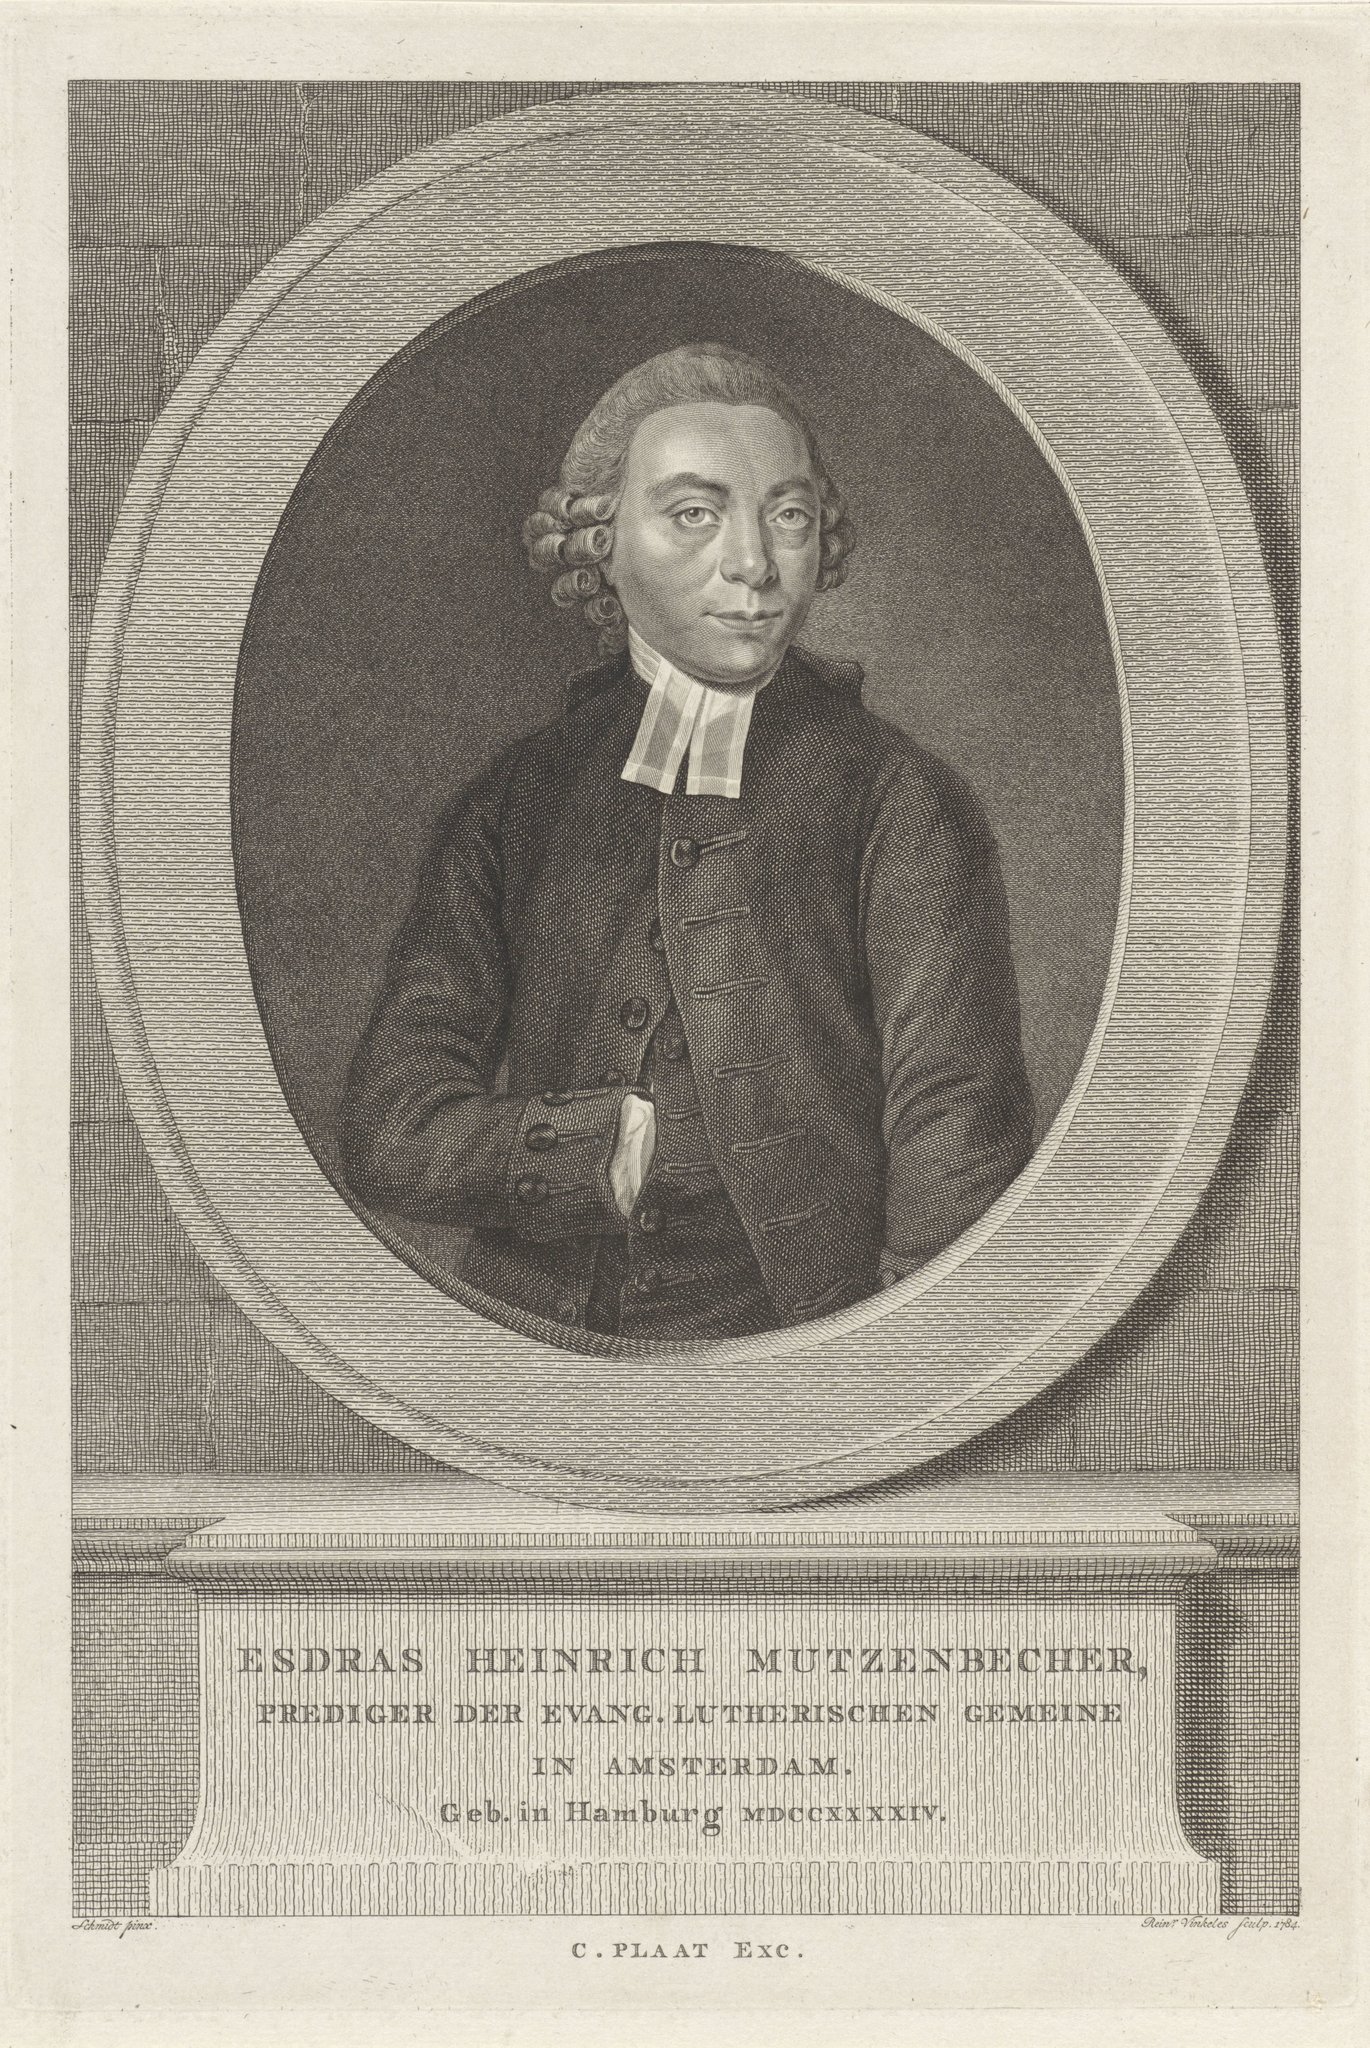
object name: print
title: Portret van de Amsterdamse predikant Esdras Heinrich Mützenbecher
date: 1784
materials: paper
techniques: engraving, etching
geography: the hague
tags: esdras heinrich mützenbecher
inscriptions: collector's mark: Lugt 2228